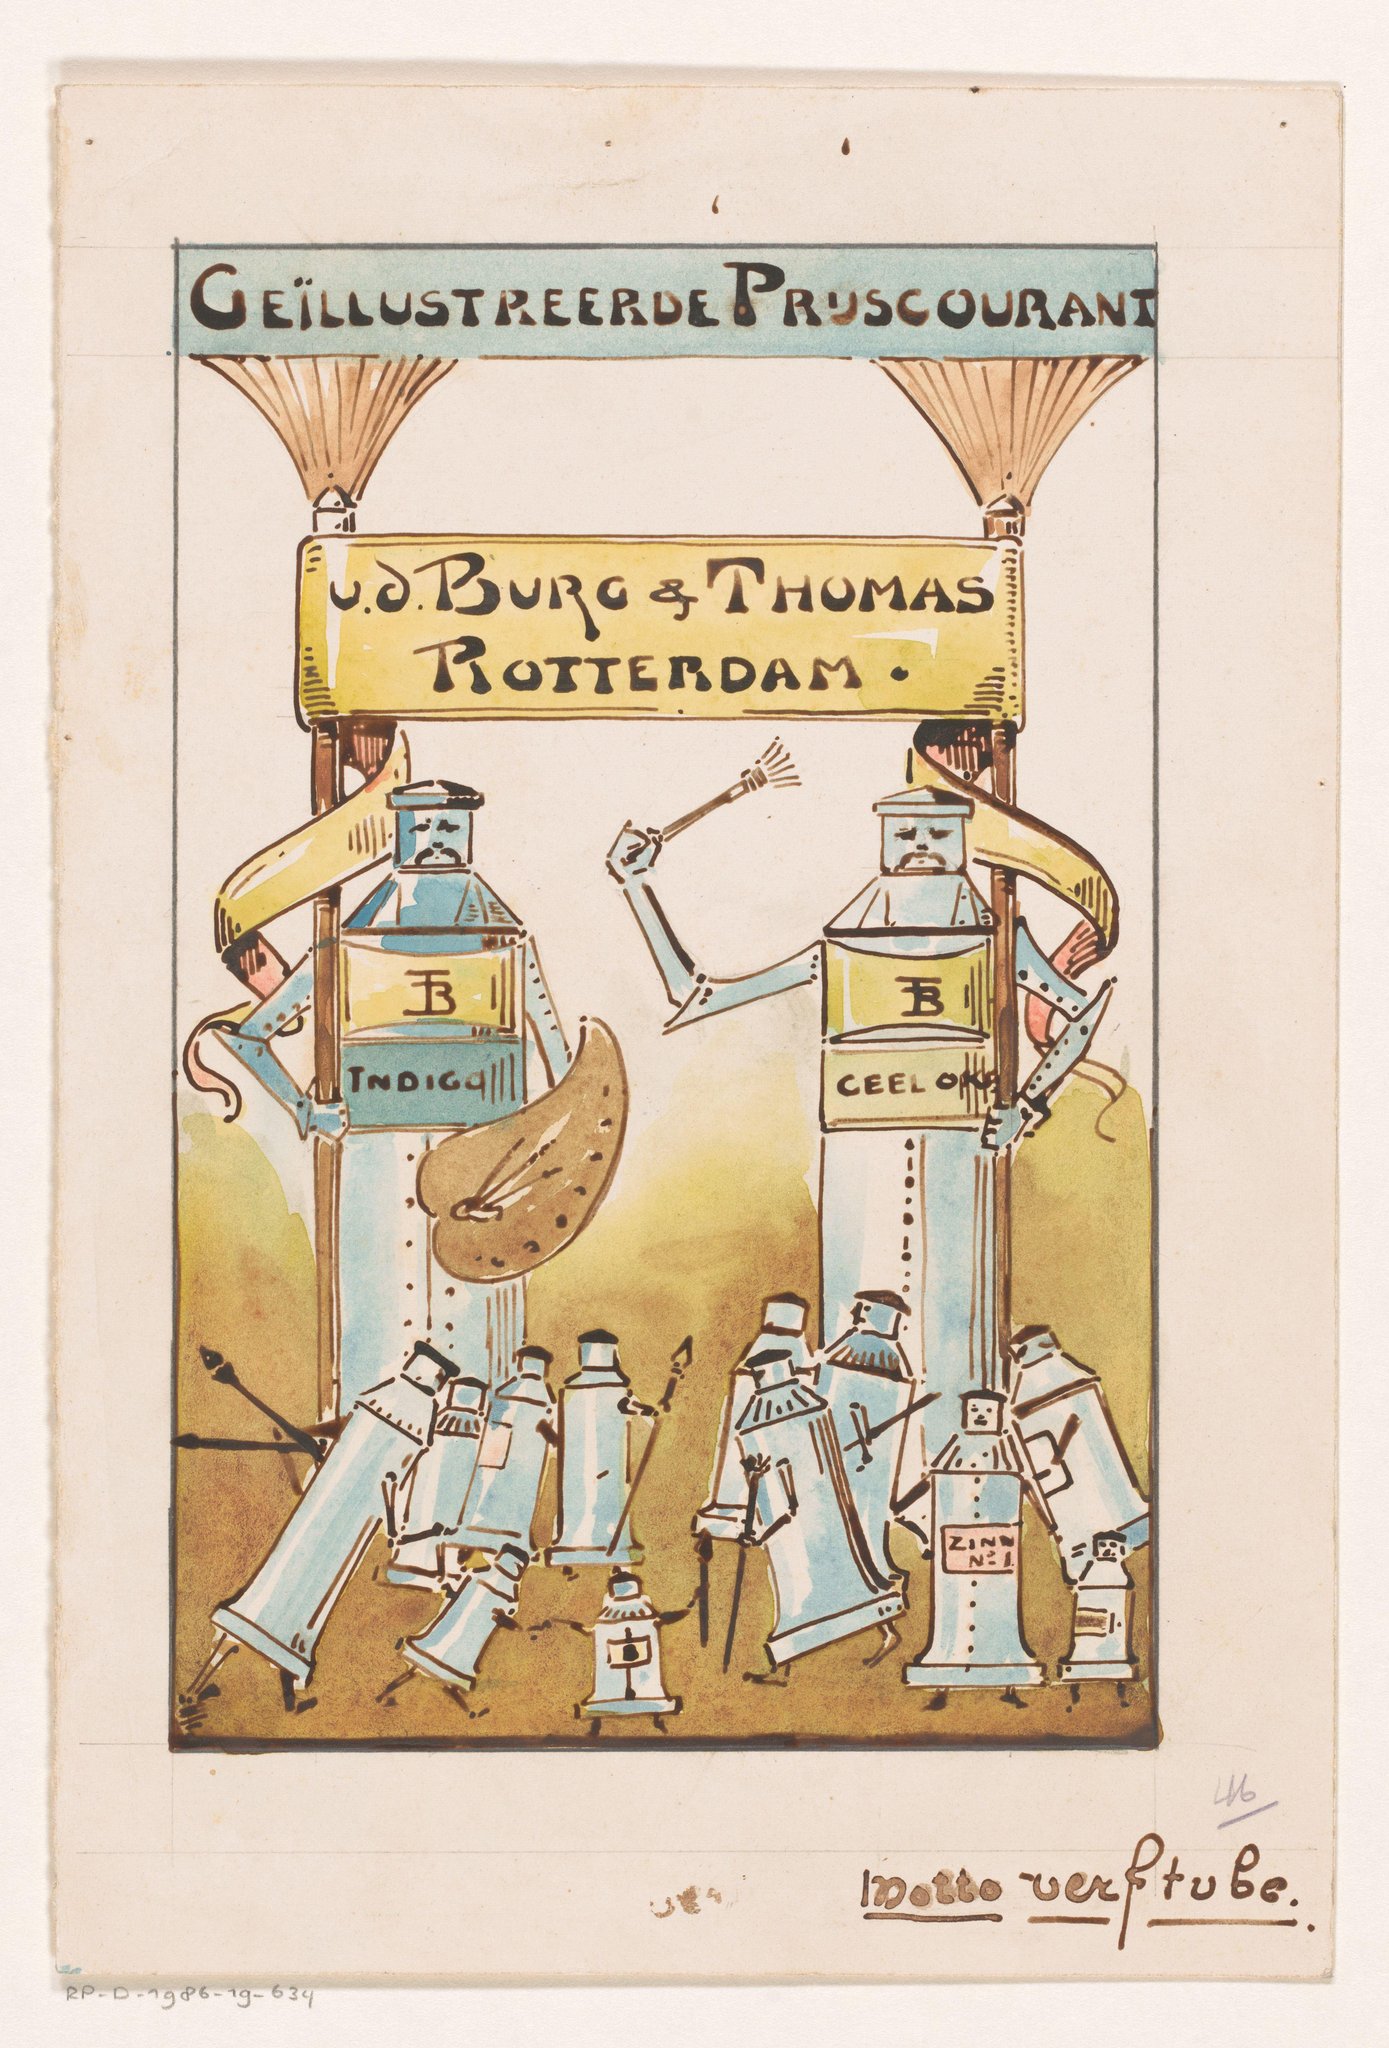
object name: drawing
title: Omslagontwerp voor: Geïllustreerde prijscourant v.d. Burg & Thomas te Rotterdam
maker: reinier willem petrus de vries (1874-1953)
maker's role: draughtsman, print maker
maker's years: 1874-1953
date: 1884-1952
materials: ink, paper, pencil, watercolor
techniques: brush, pen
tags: tools, implements of painter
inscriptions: number: ‘46’, annotation: ‘motto verftube.’, collector's mark: ‘R:MVS.’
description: Twee verftubes met gezichten staan als wachters bij een poort. Ze dragen elk een waaierkwast waartussen een banier is gespannen met de tekst 'v.d. Burg & Thomas Rotterdam'. Kleinere verftubes, eveneens met gezichten, lopen richting de gecreëerde poort.